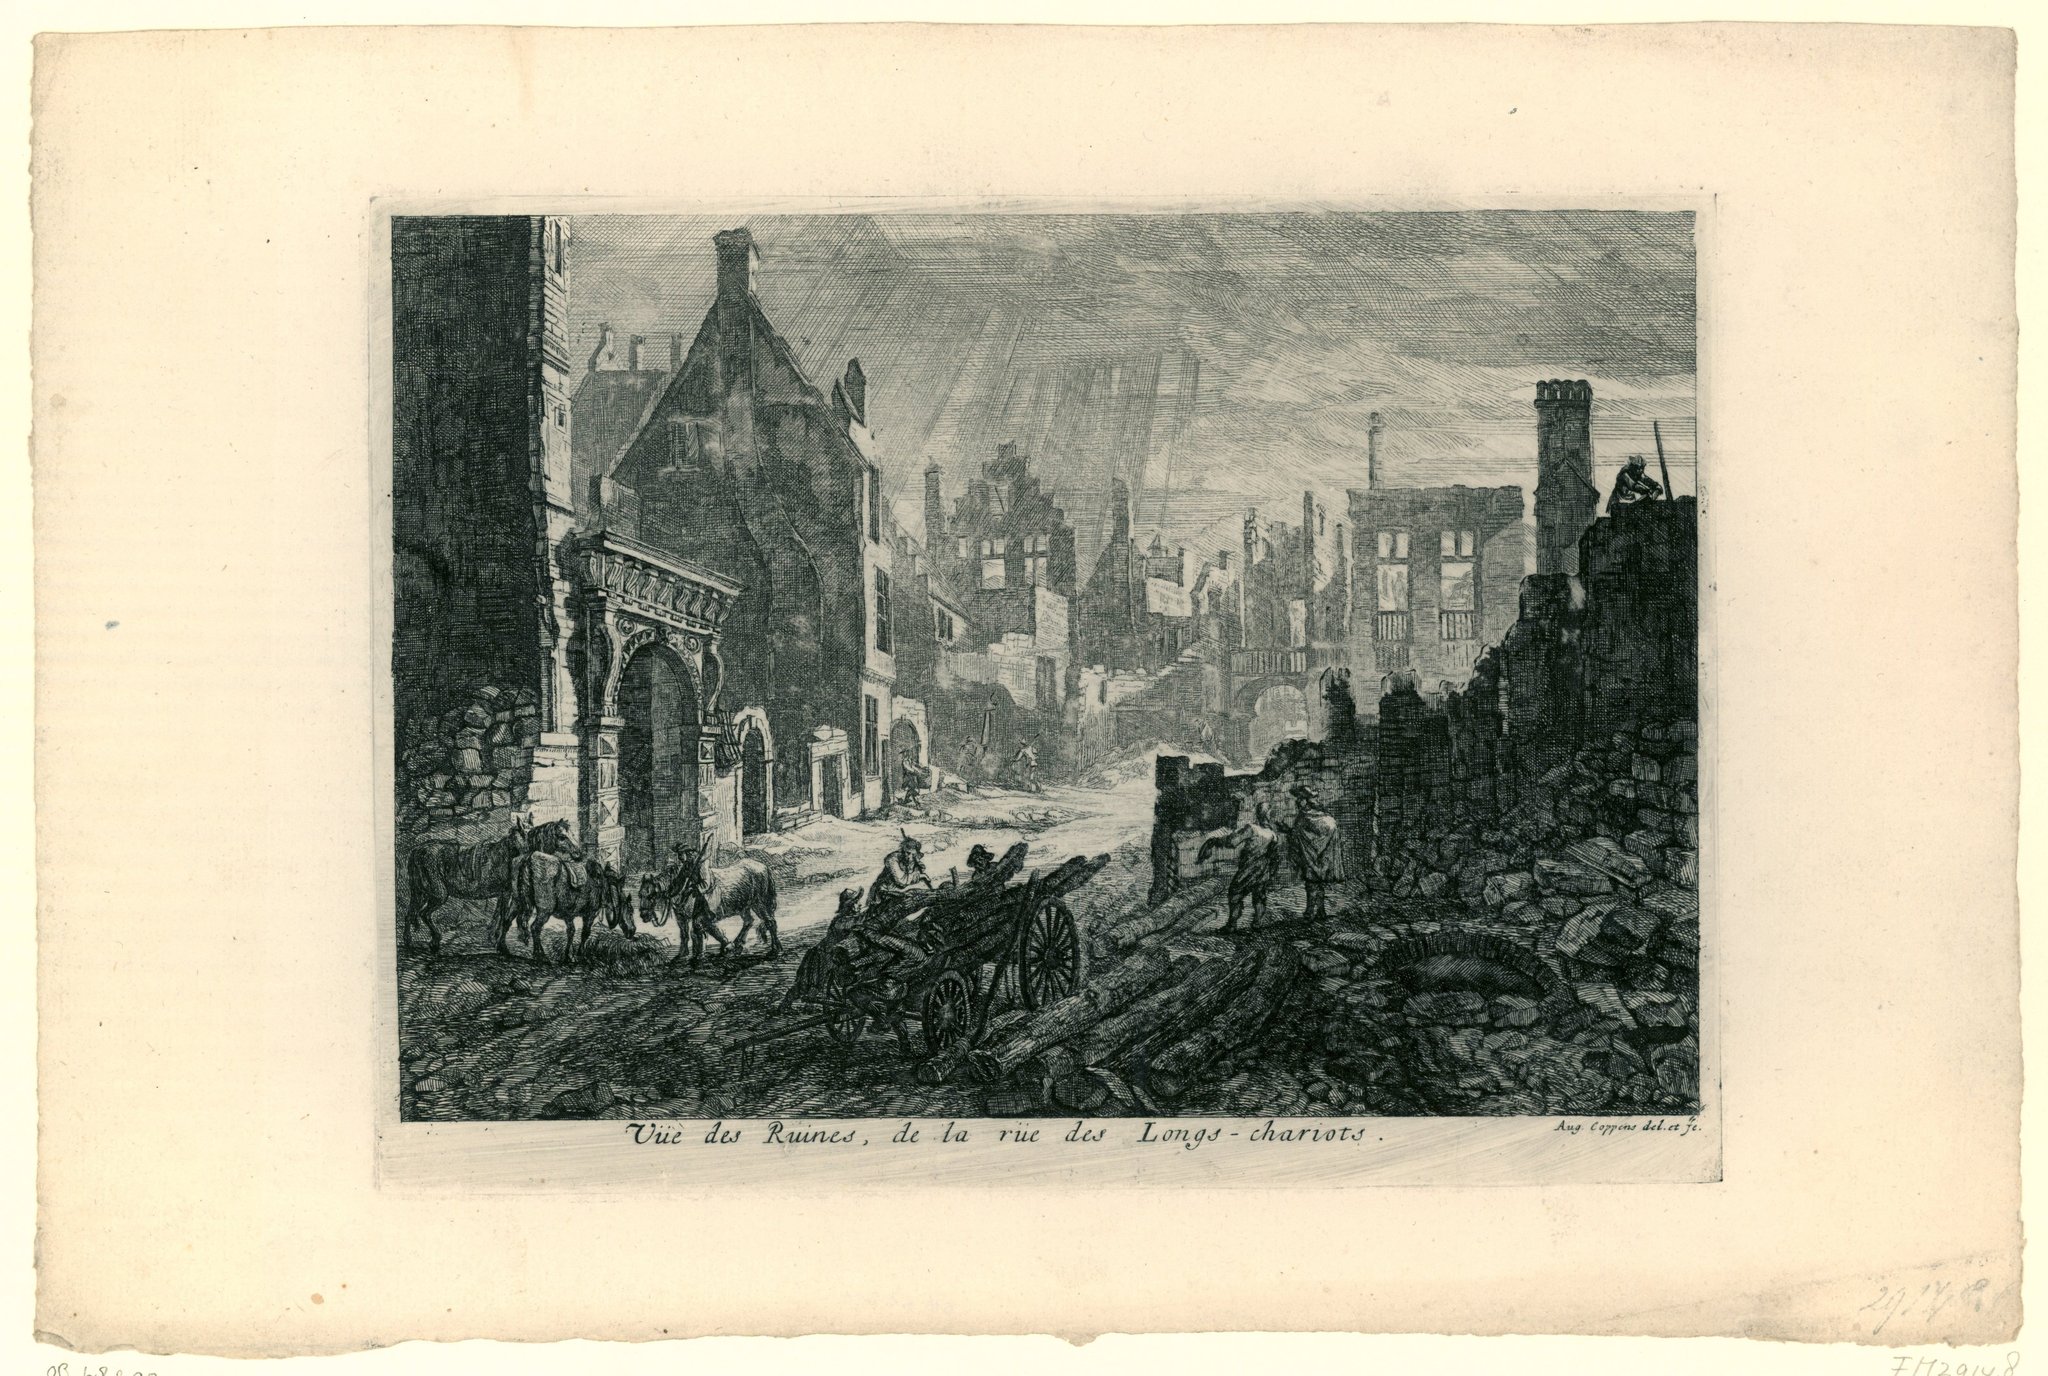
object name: print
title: Perspectives des ruines de la ville de Bruxelles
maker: augustin coppens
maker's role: print maker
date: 1695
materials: paper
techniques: etching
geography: southern netherlands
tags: devastated, ruined place or city (~ warfare), brussels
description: Voorstelling van de ruïnes in de Wagenstraat (?) te Brussel na het bombardement door de Fransen, 13-15 augustus 1695. Achtste prent in de reeks van twaalf.